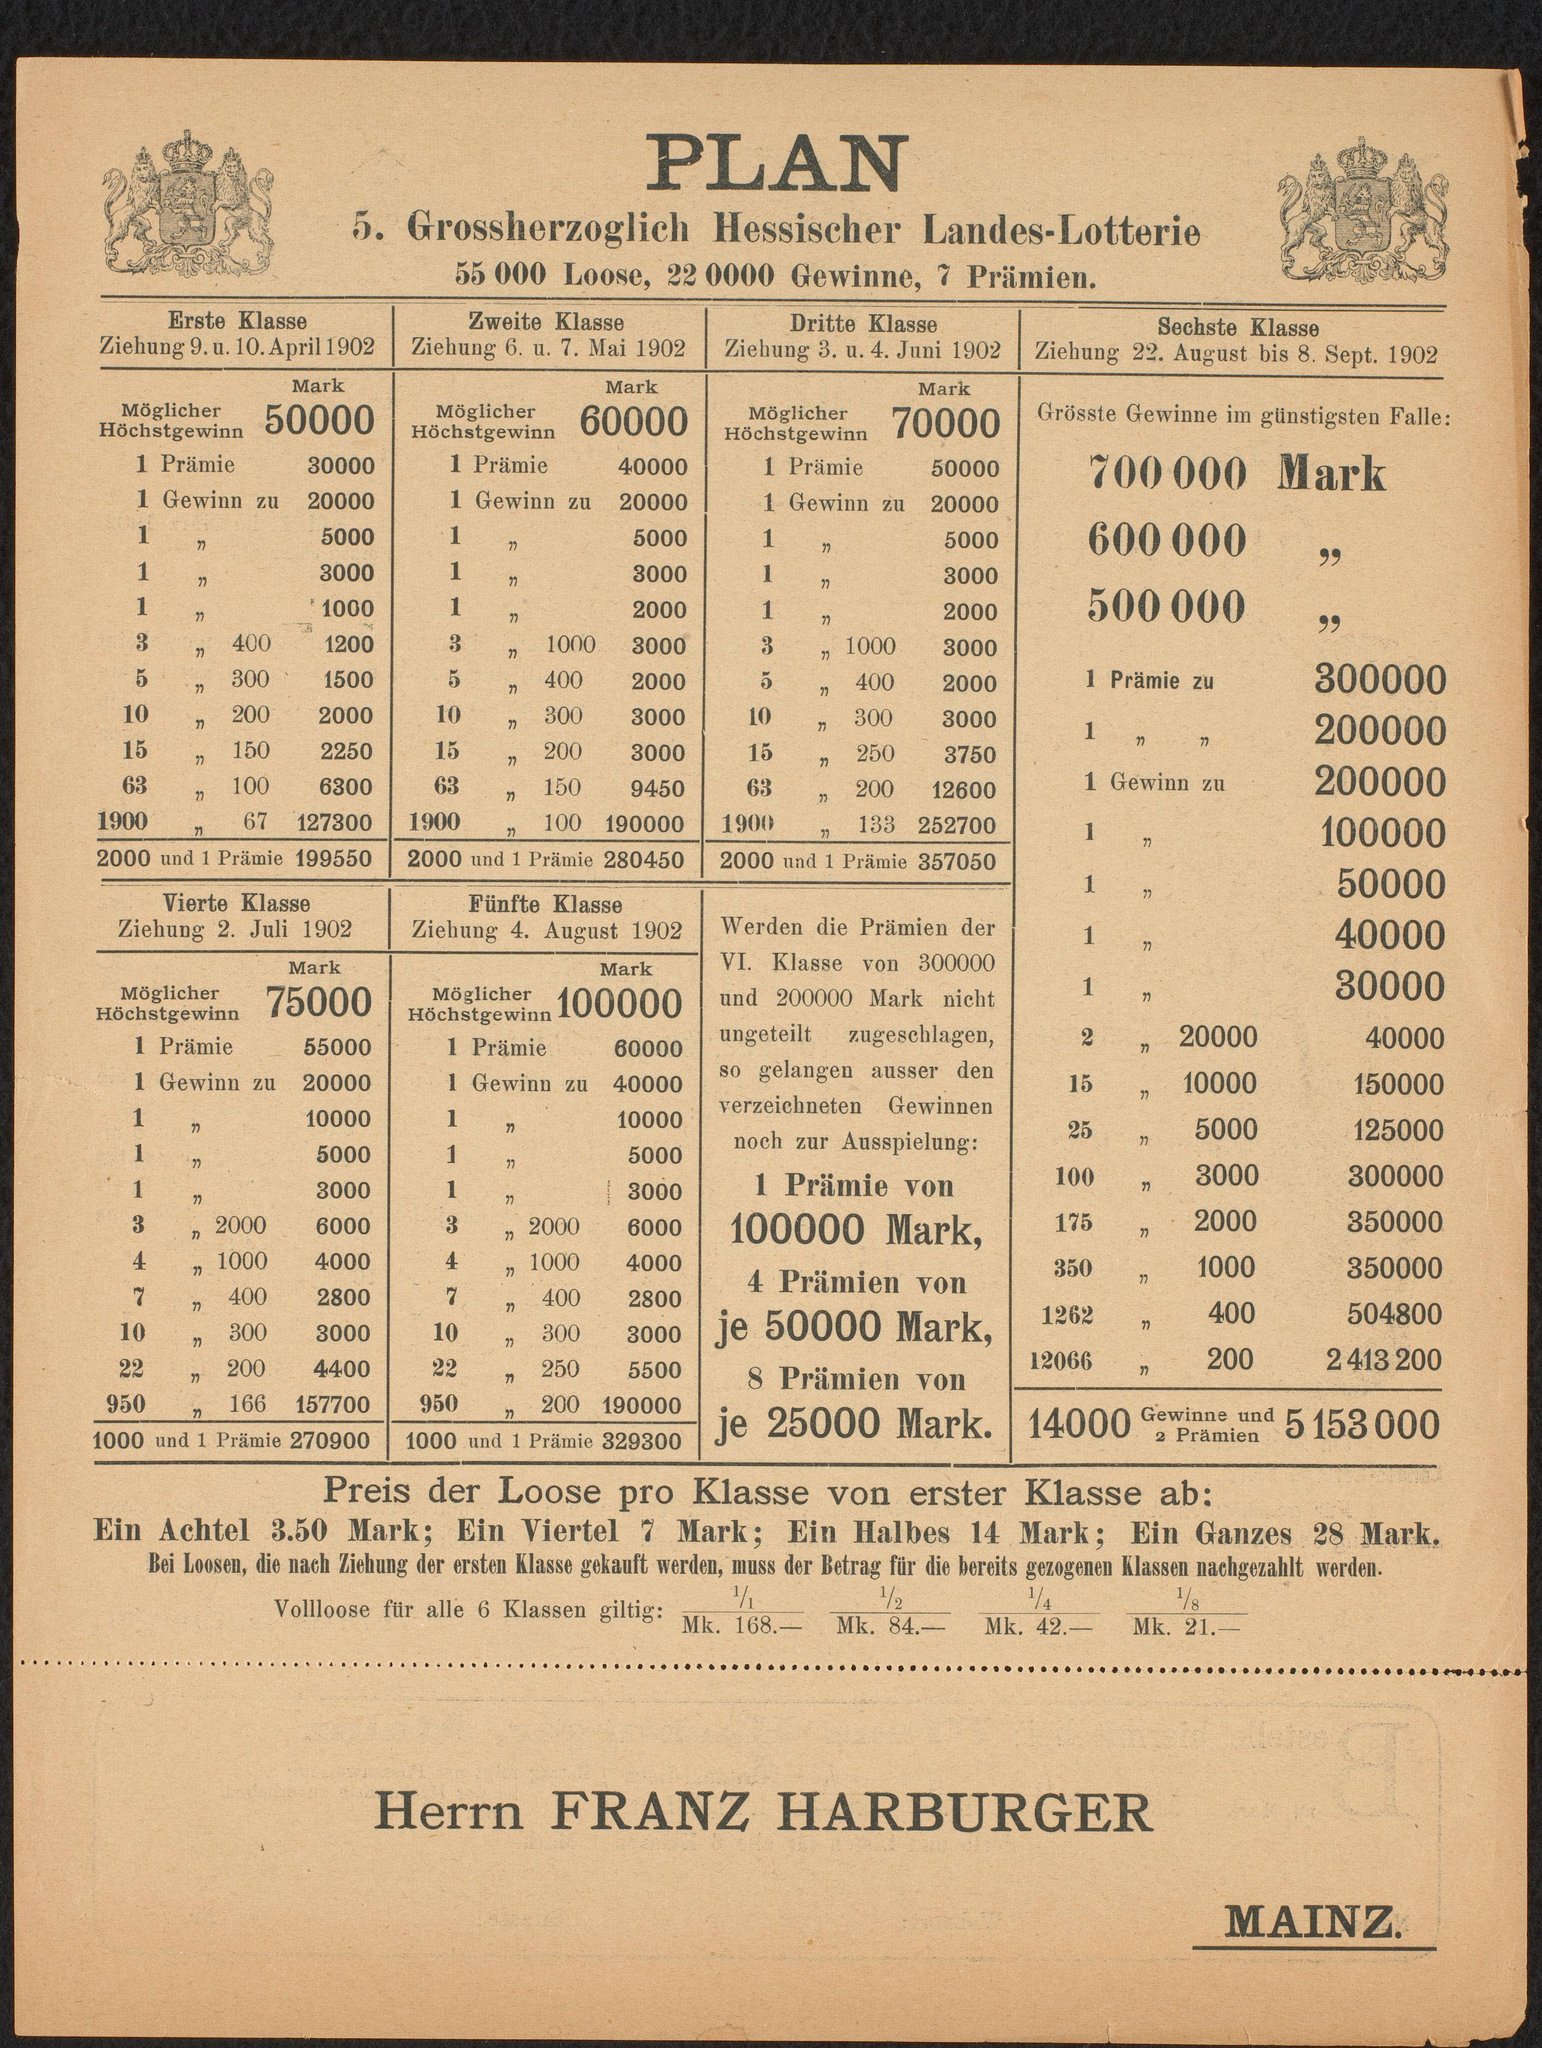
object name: photomechanical print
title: Overzicht van de te winnen prijzen bij de Grossherzoglich Hessischer Landes-Lotterie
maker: Anonymous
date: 1902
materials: paper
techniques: offset printed, perforating, printing block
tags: printed matter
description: Bij gebrek aan gegevens over de vervaardiger is voor de bepaling van de rechten van dit object gebruik gemaakt van de vervaardigingsdatum.